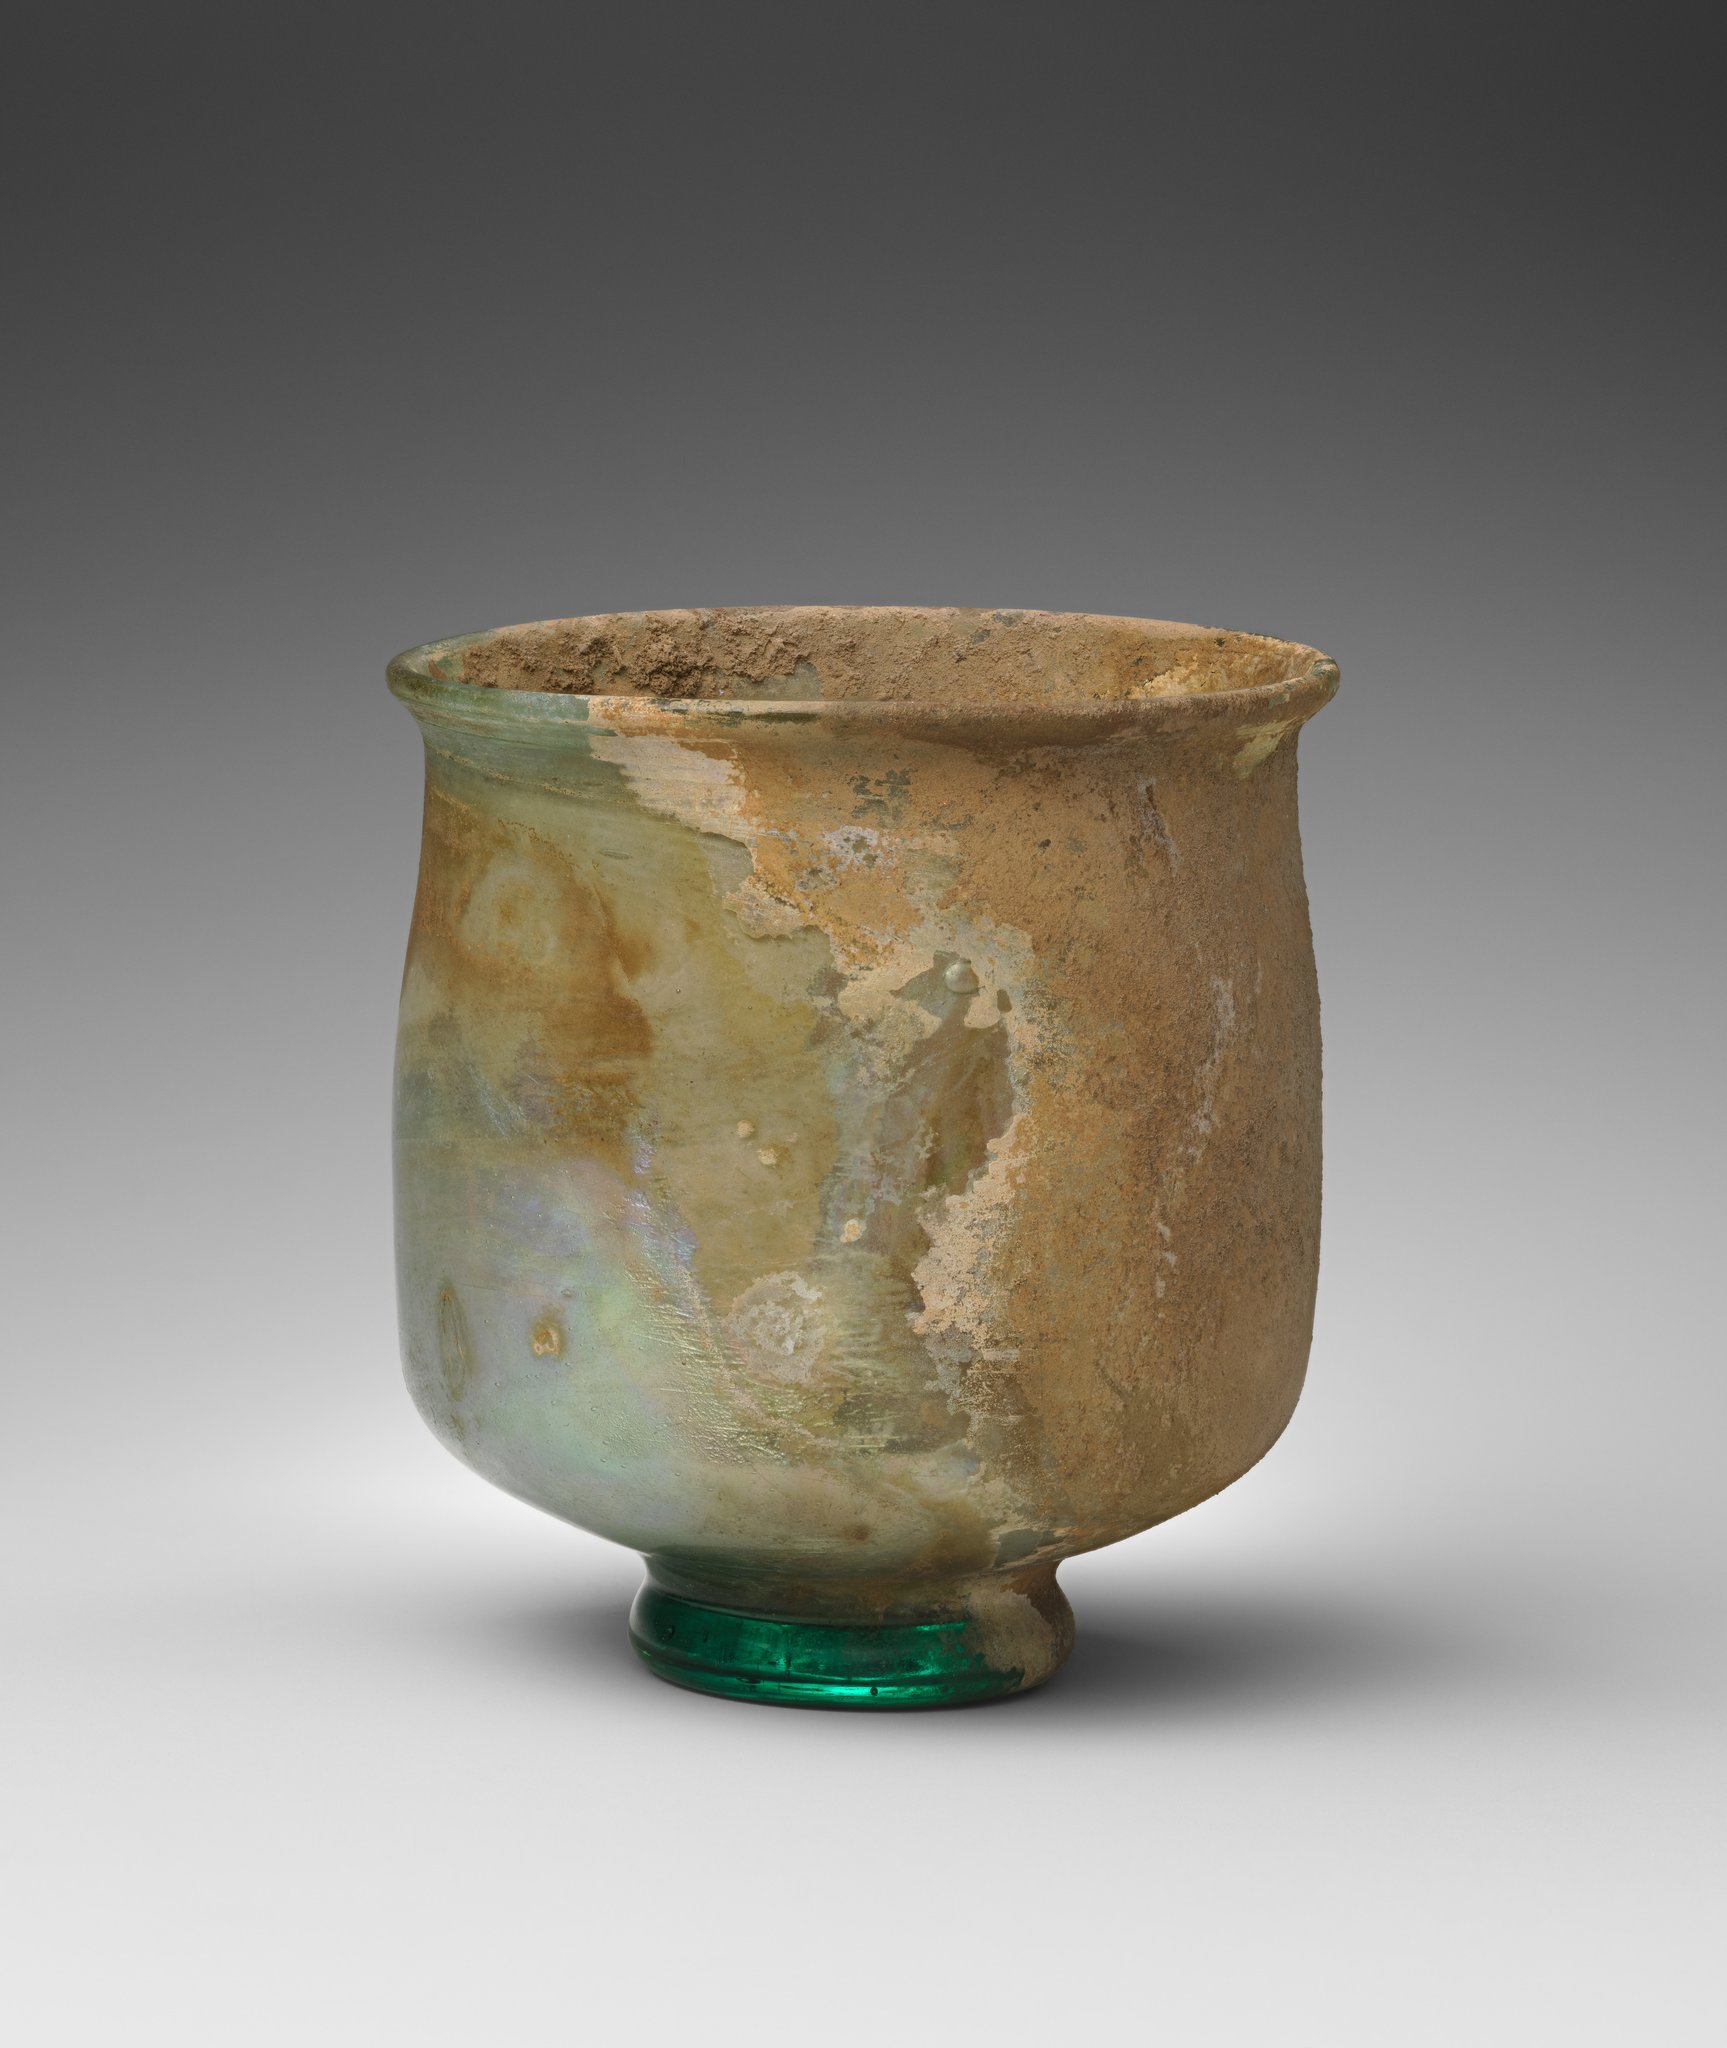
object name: cup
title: Glass cup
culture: roman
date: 301-400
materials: glass